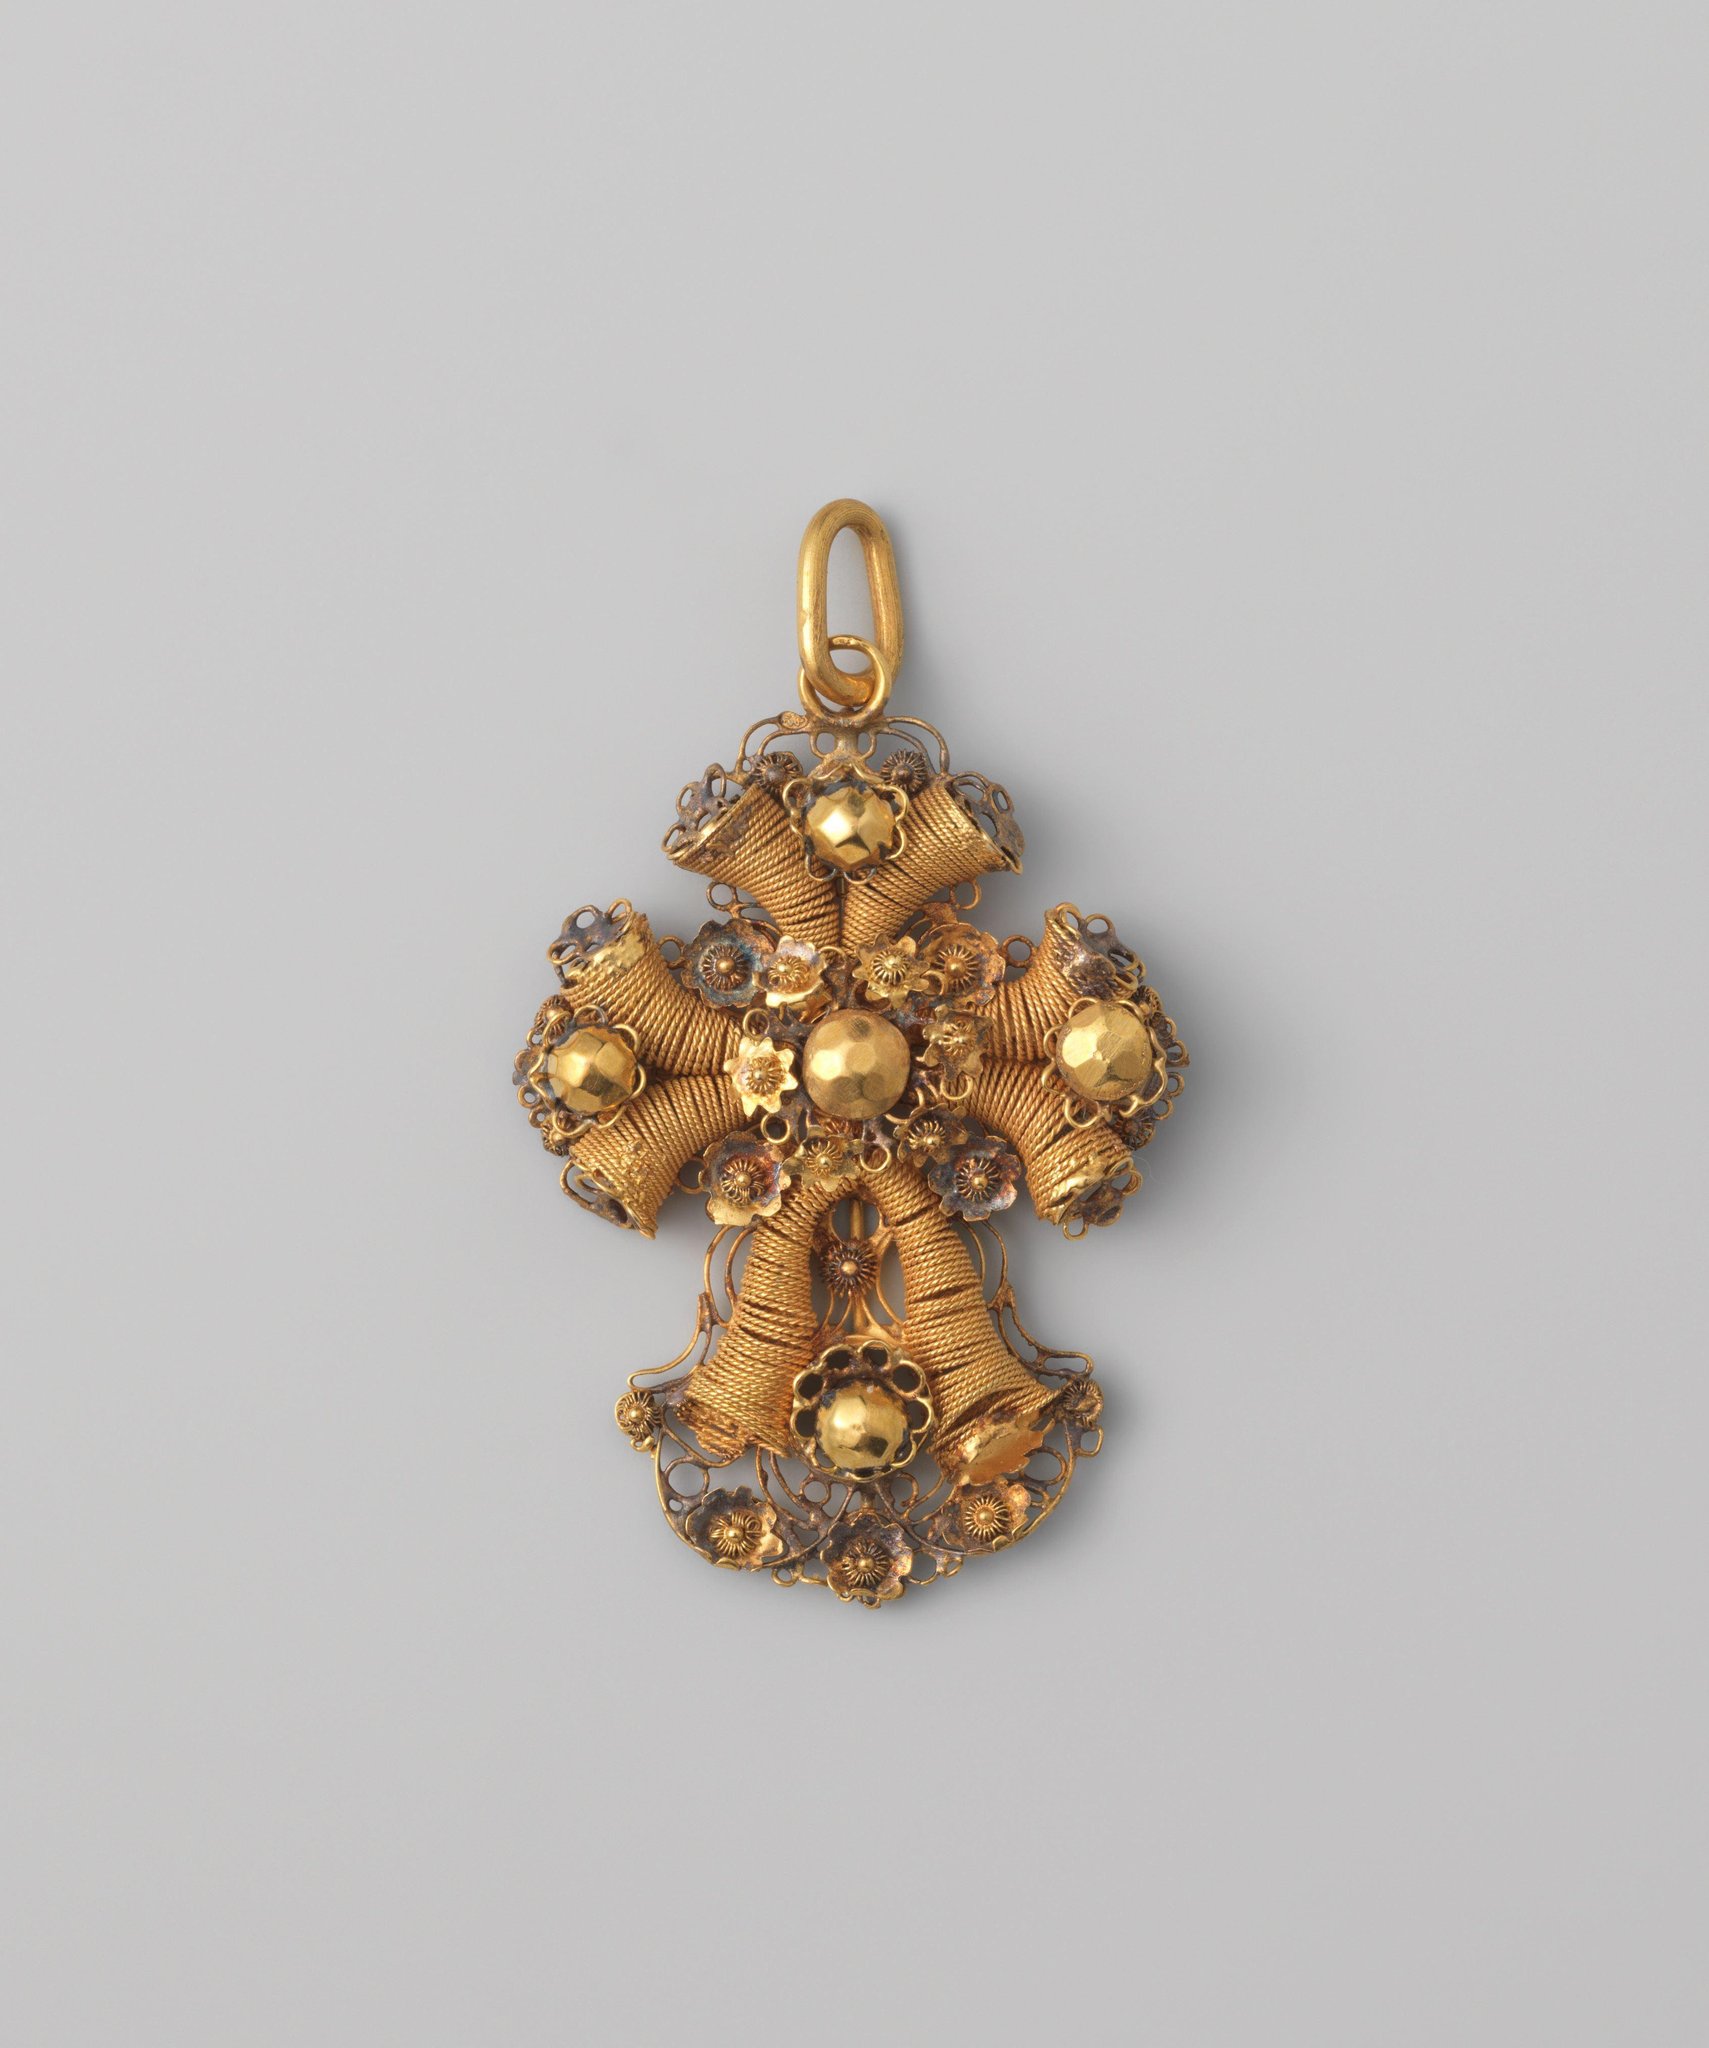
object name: pendant jewelry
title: Hanger in de vorm van een kruis gevormd door horens die eindigen in een rozet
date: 1840-1850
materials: gold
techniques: filigree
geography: netherlands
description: Hanger van goud in de vorm van een kruis. De balken van het kruis worden gevormd door telkens twee horens van gouddraad. De mond van deze horens is afgesloten door een rozet. In het hart van het kruis een grote rozet. Gemerkt: eikeblaadje.